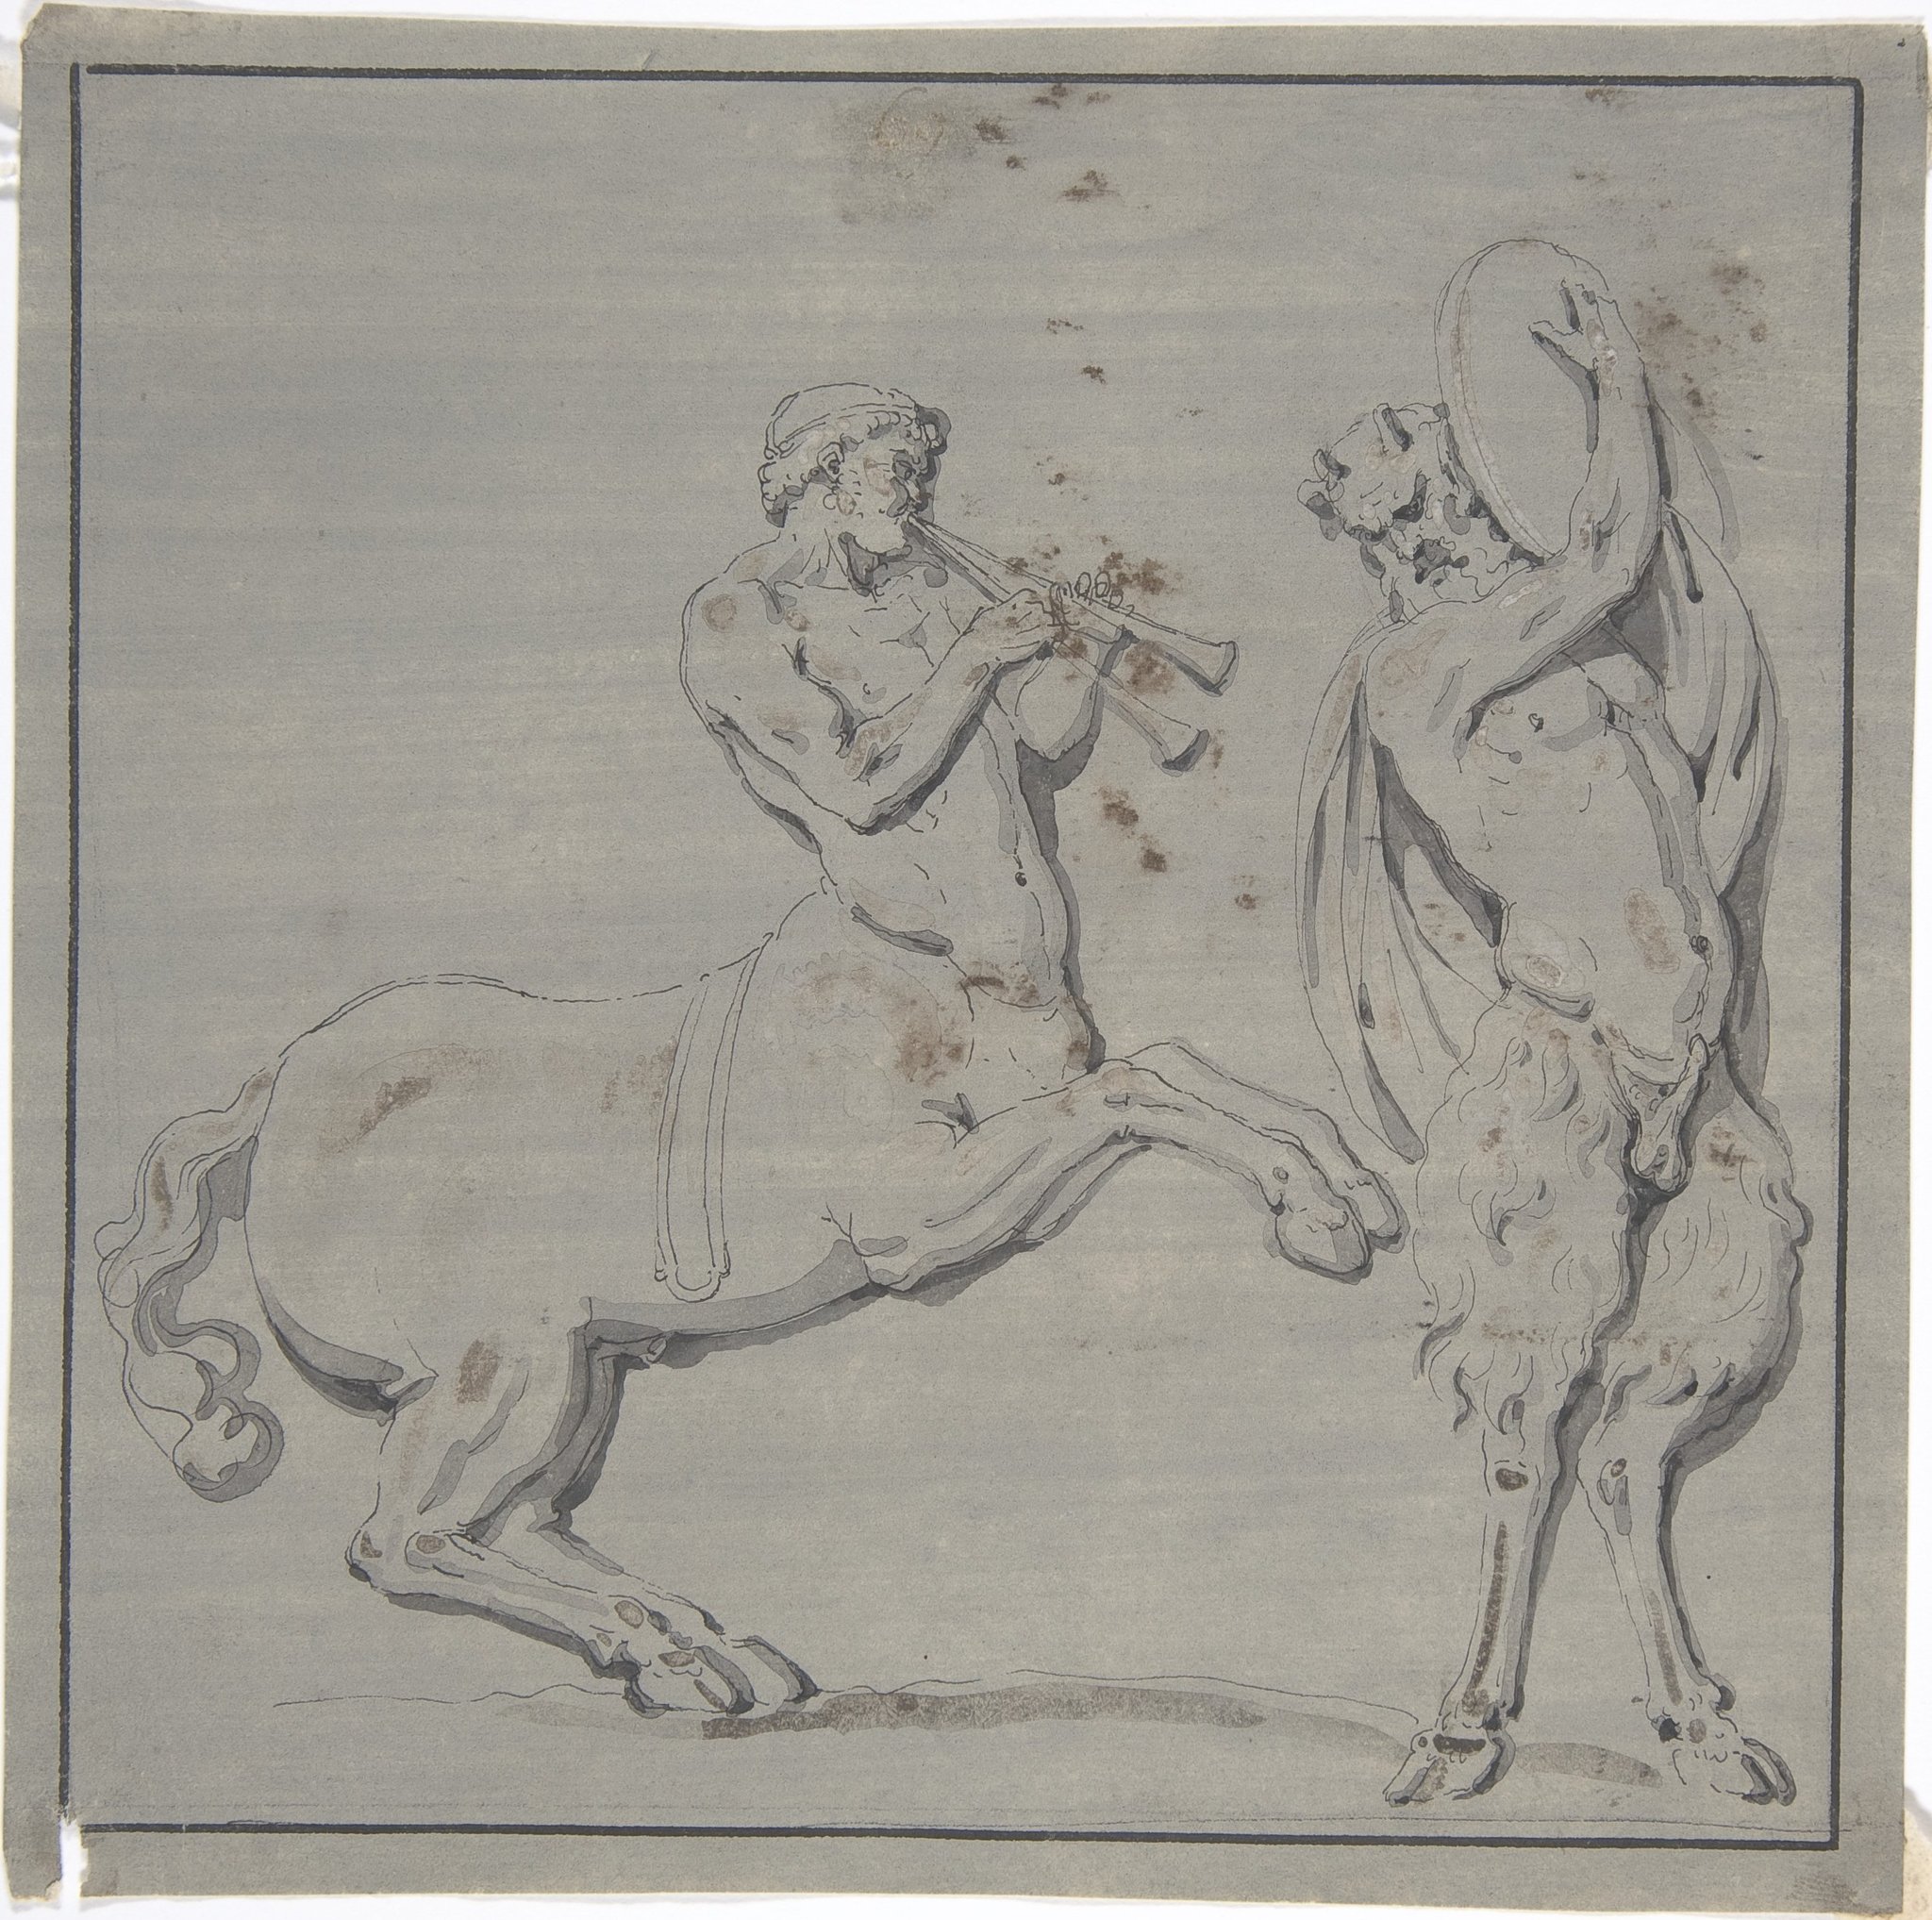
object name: drawing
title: Bacchic Scene of Centaur Playing Horns and Satyr with Drum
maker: anonymous, french, 18th century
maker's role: artist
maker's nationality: french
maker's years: 1700-1800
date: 1701-1800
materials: ink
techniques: brush, pen, wash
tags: drums,horns,centaurs,satyrs